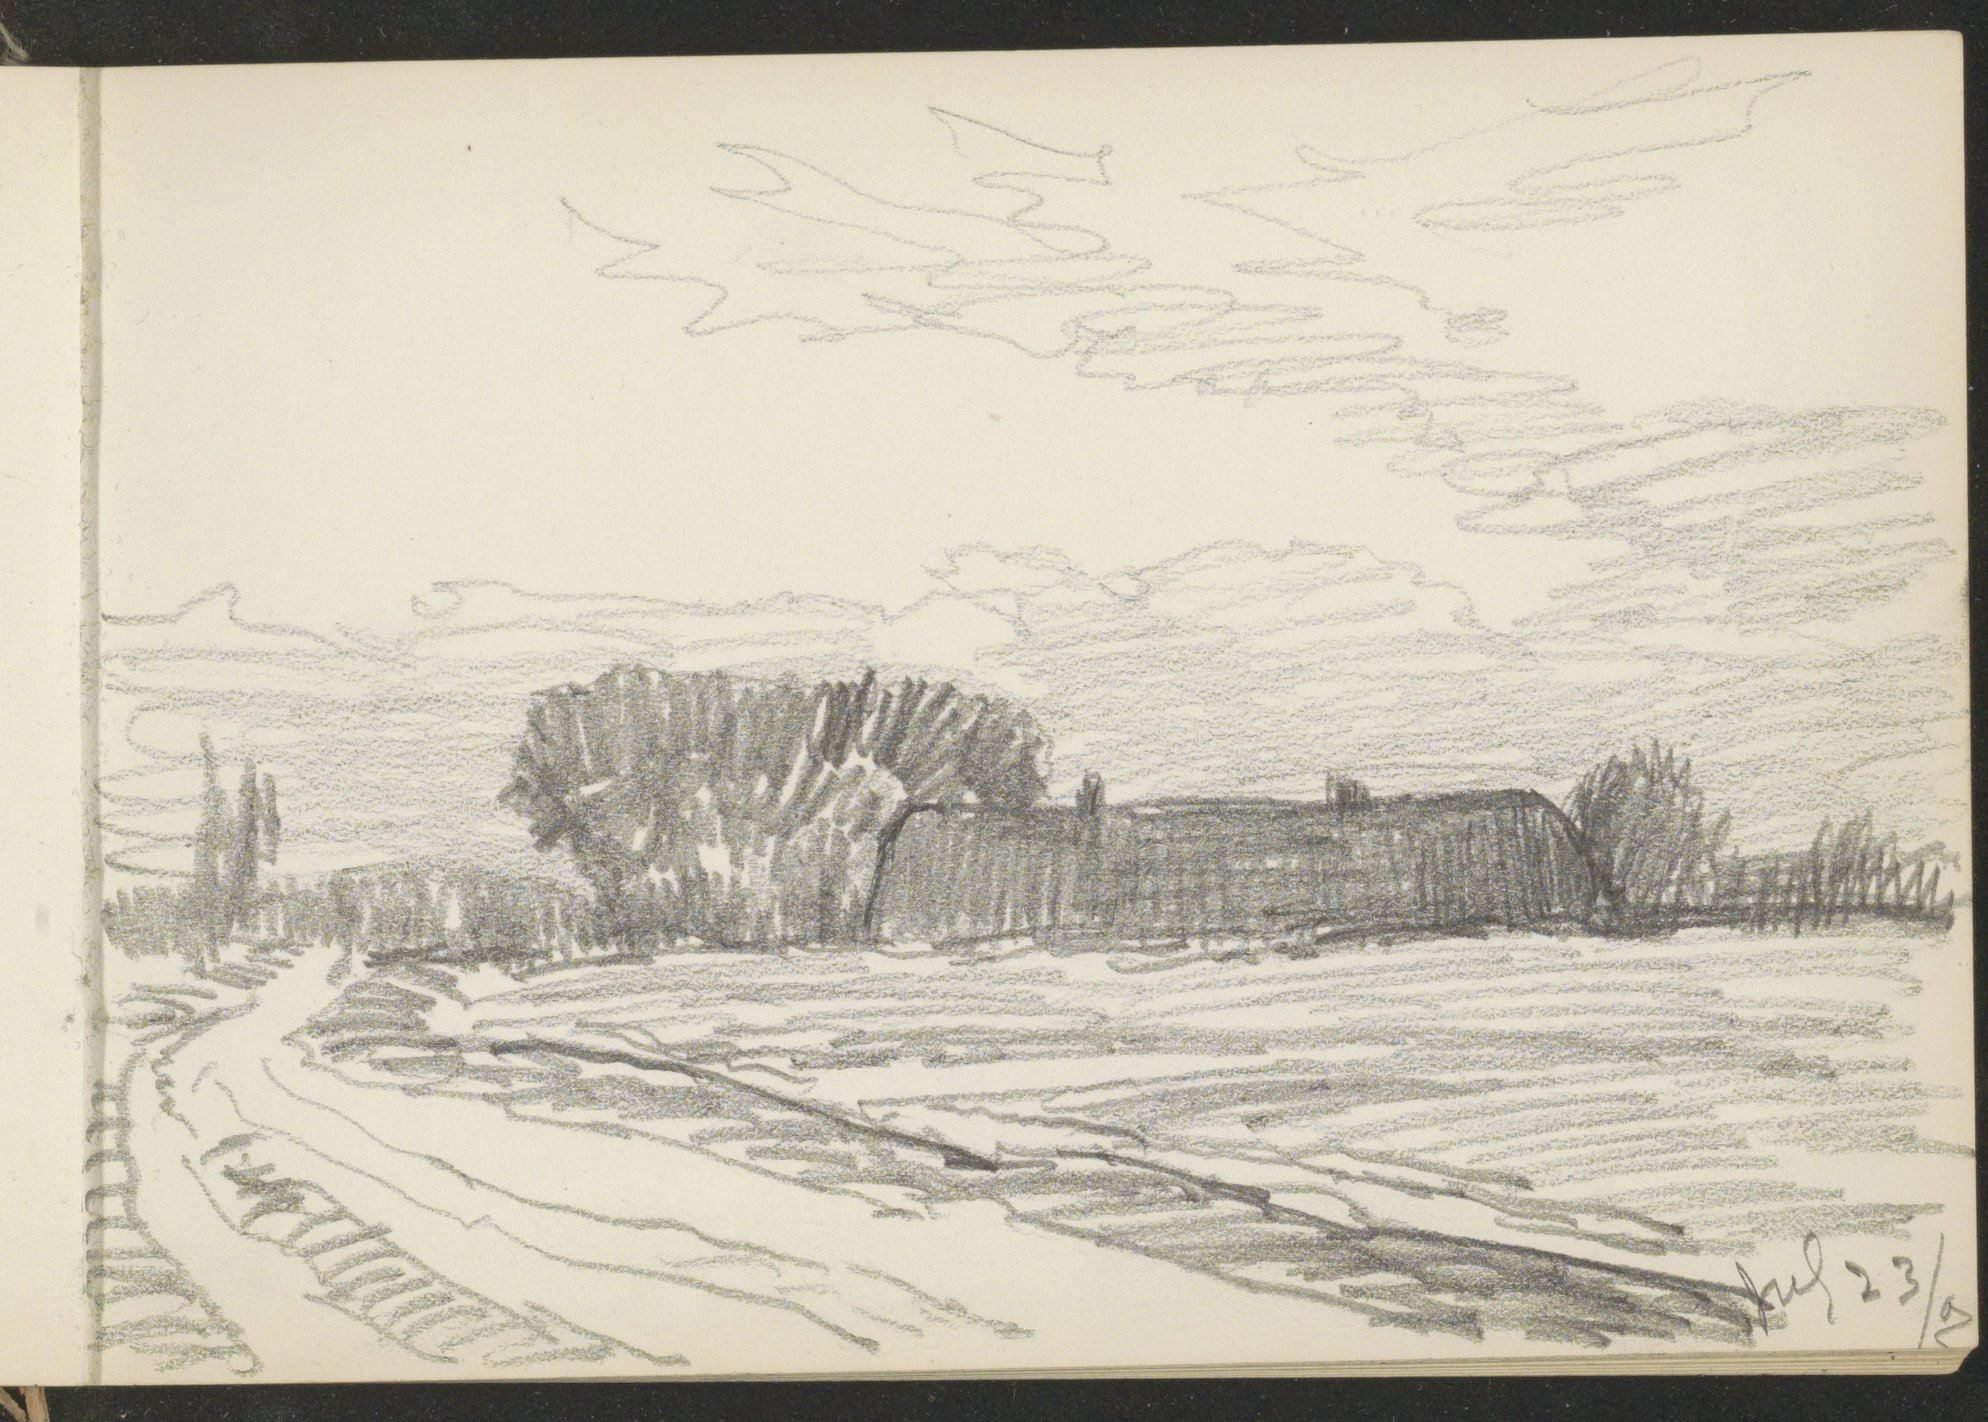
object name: sketchbook leaf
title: Landschap met boerderij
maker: alexander shilling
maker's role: draughtsman, print maker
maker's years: 1859-1937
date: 1907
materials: paper, pencil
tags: fence, wall, paling, farm (building)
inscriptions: date: ‘Jul 23/07’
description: Blad 15 recto uit een schetsboek met 24 bladen.